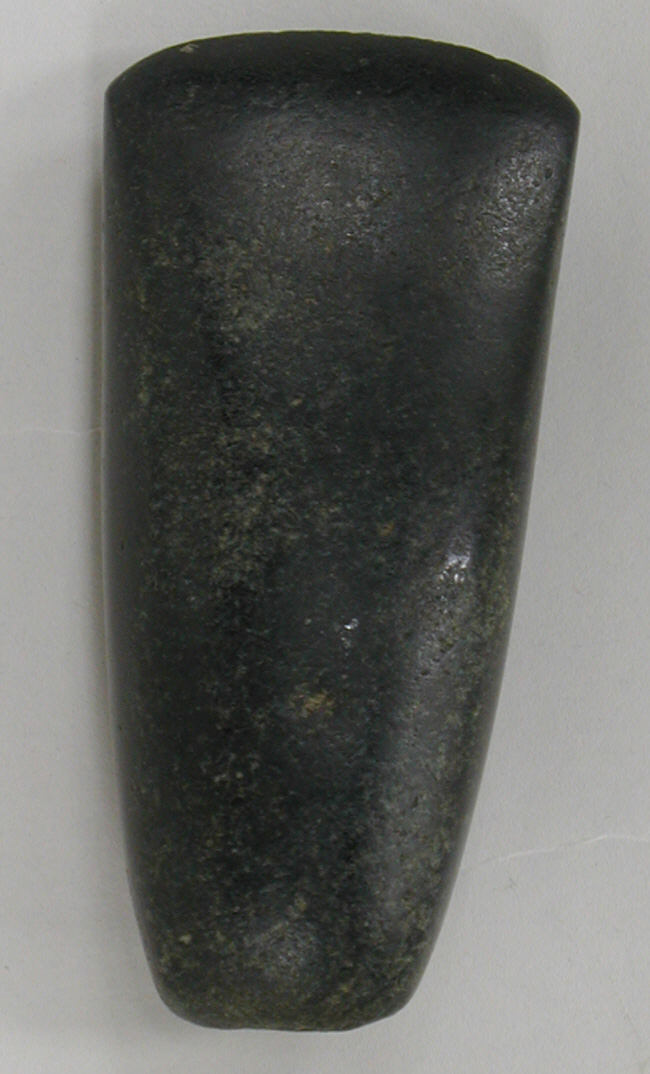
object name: celt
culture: maya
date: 1501-1600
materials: stone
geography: guatemala